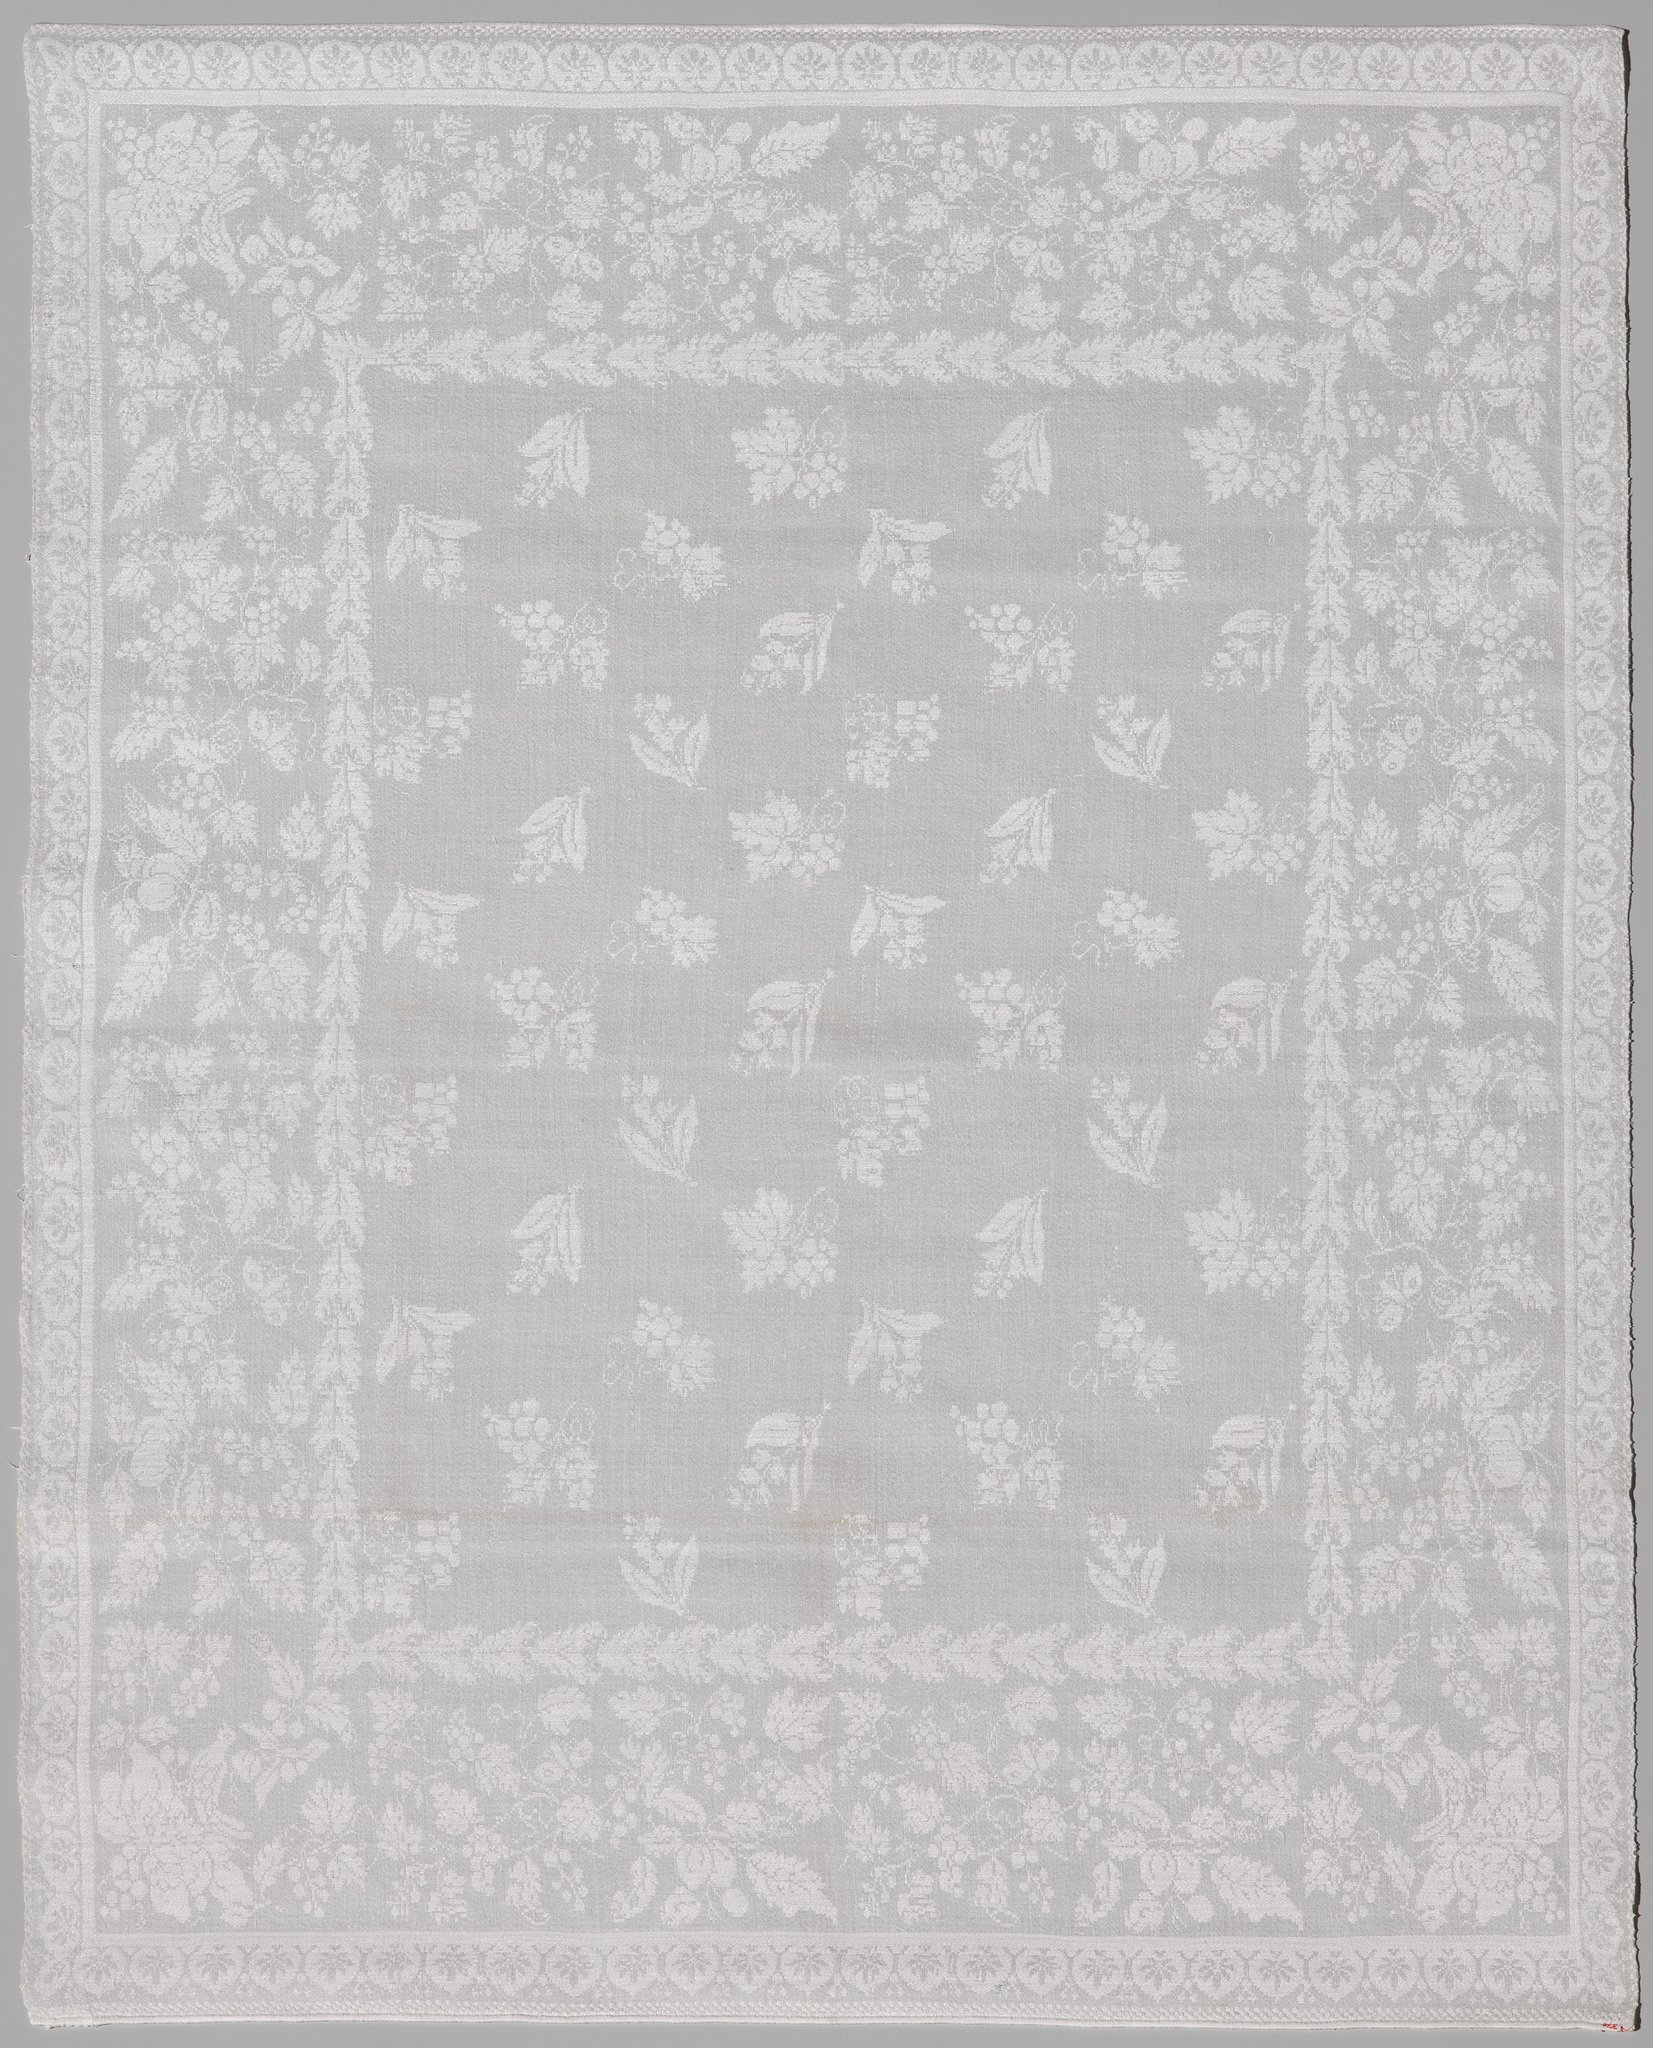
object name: napkin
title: Servet van linnendamast met een bloempatroon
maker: Anonymous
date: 1800-1850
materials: linen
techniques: damask, weave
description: Servet van linnendamast met gestrooide bloemtakken.